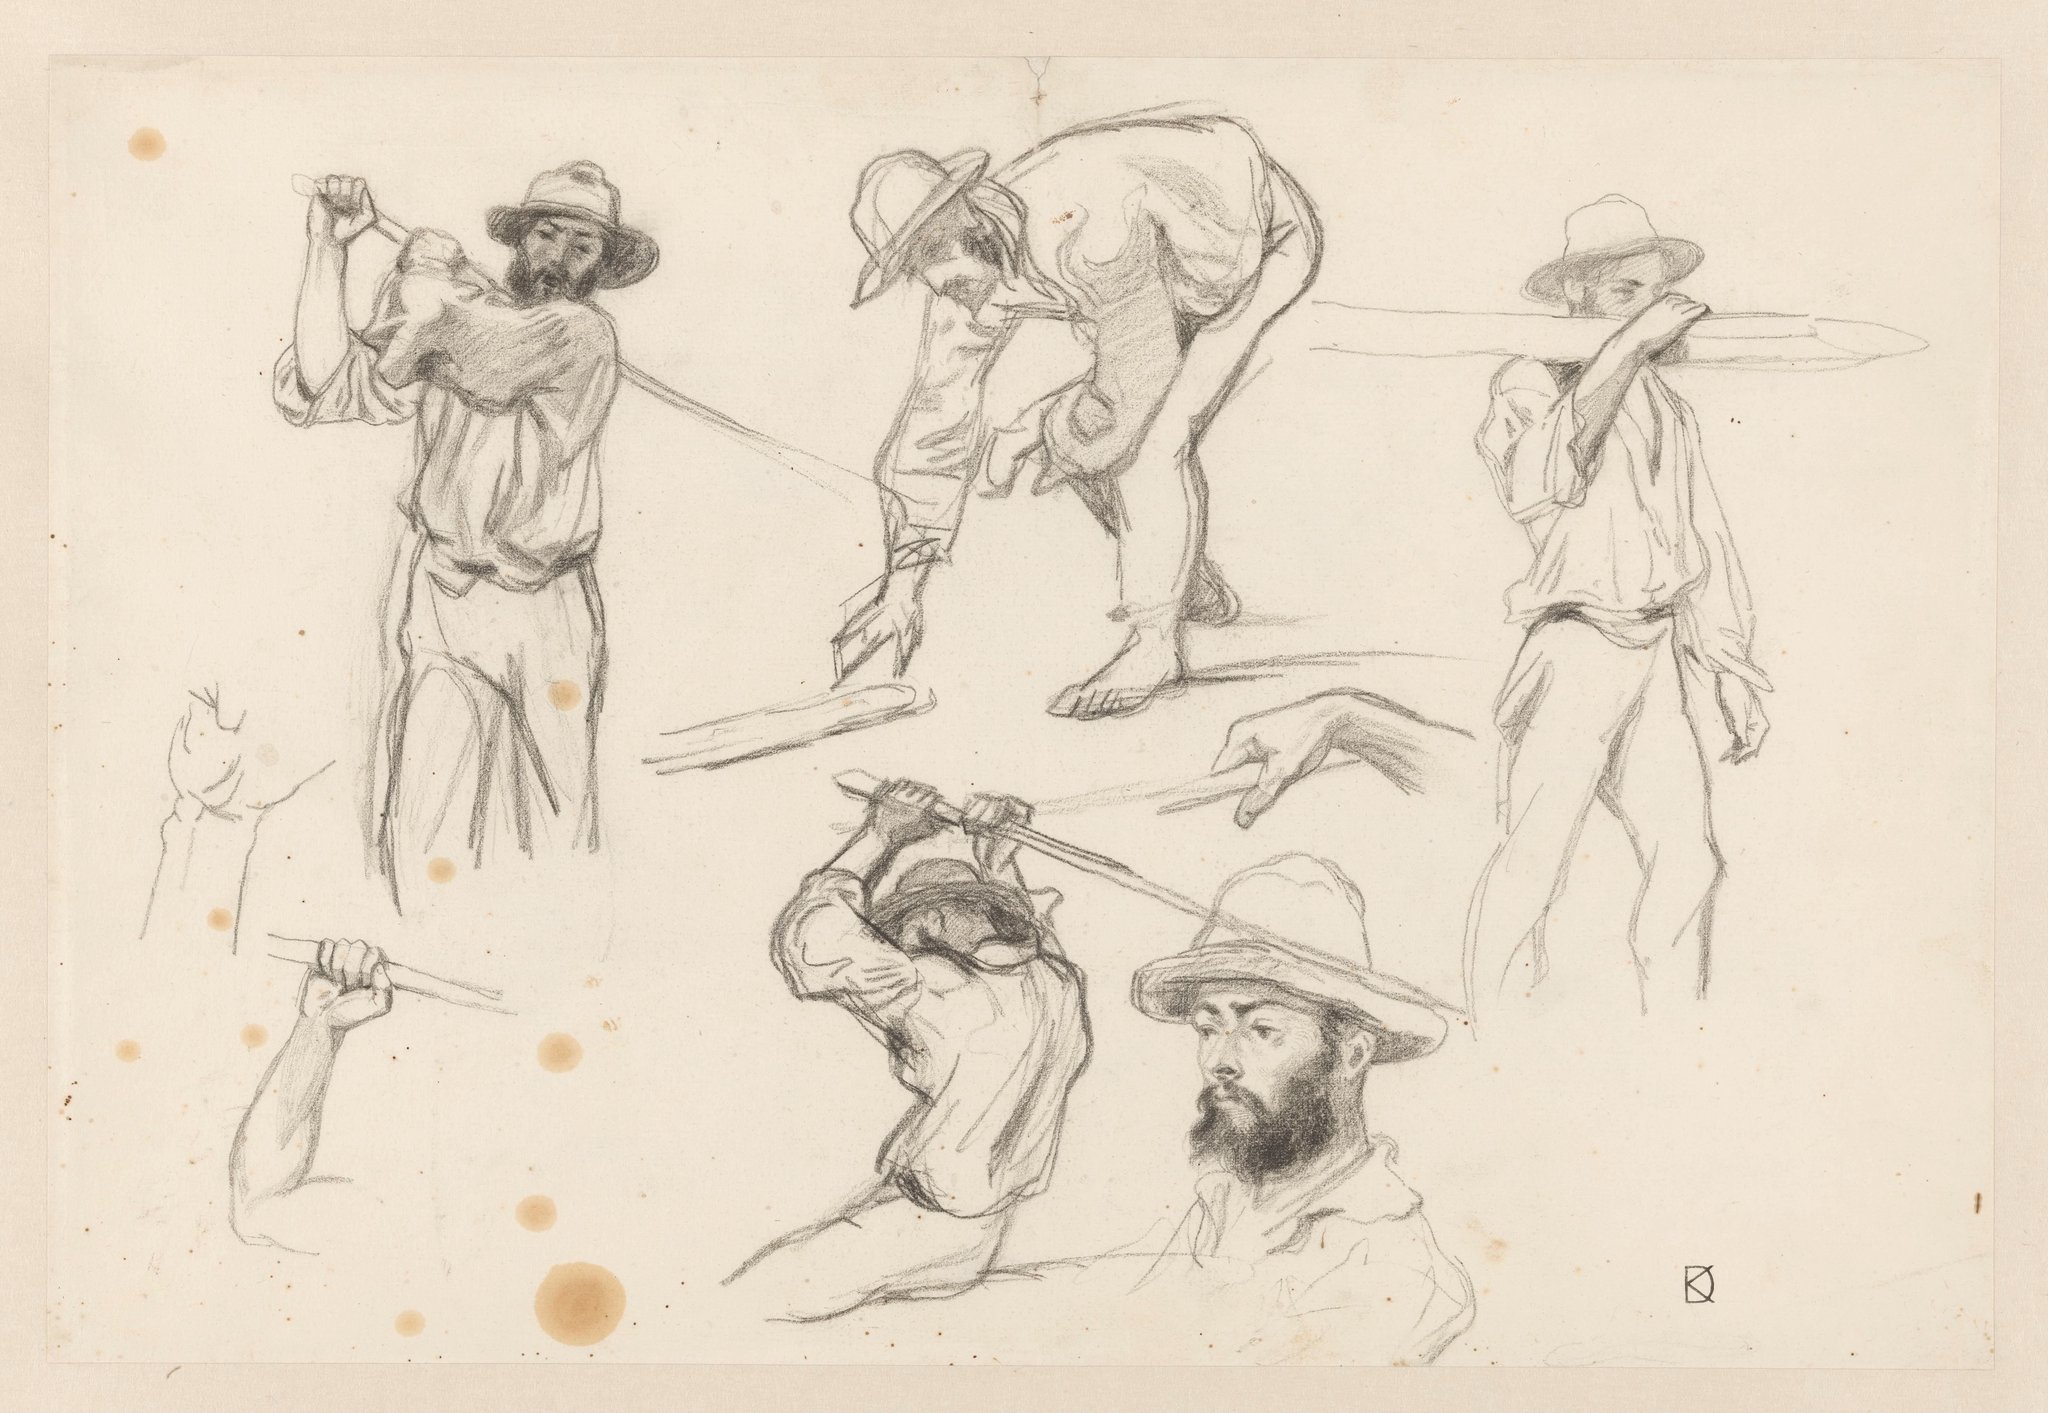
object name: drawing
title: Studies van een werkende man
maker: johan daniël koelman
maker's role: draughtsman, print maker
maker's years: 1831-1857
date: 1841-1857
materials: chalk, paper